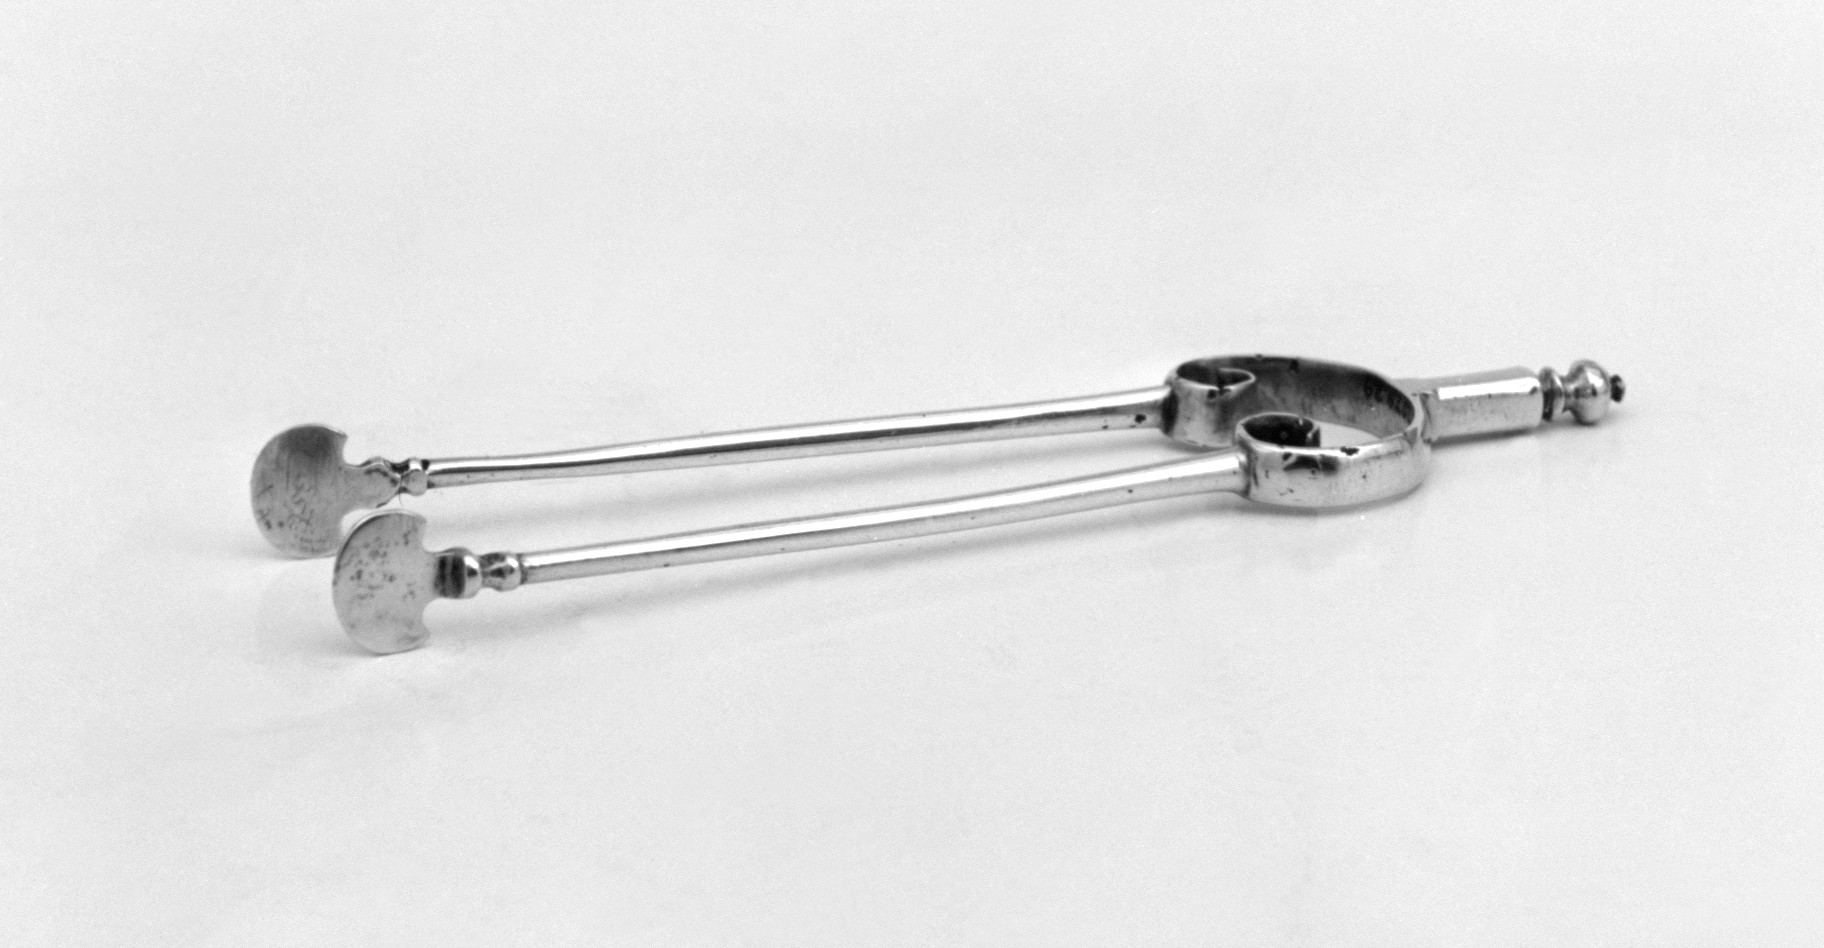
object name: douter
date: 1701-1750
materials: silver